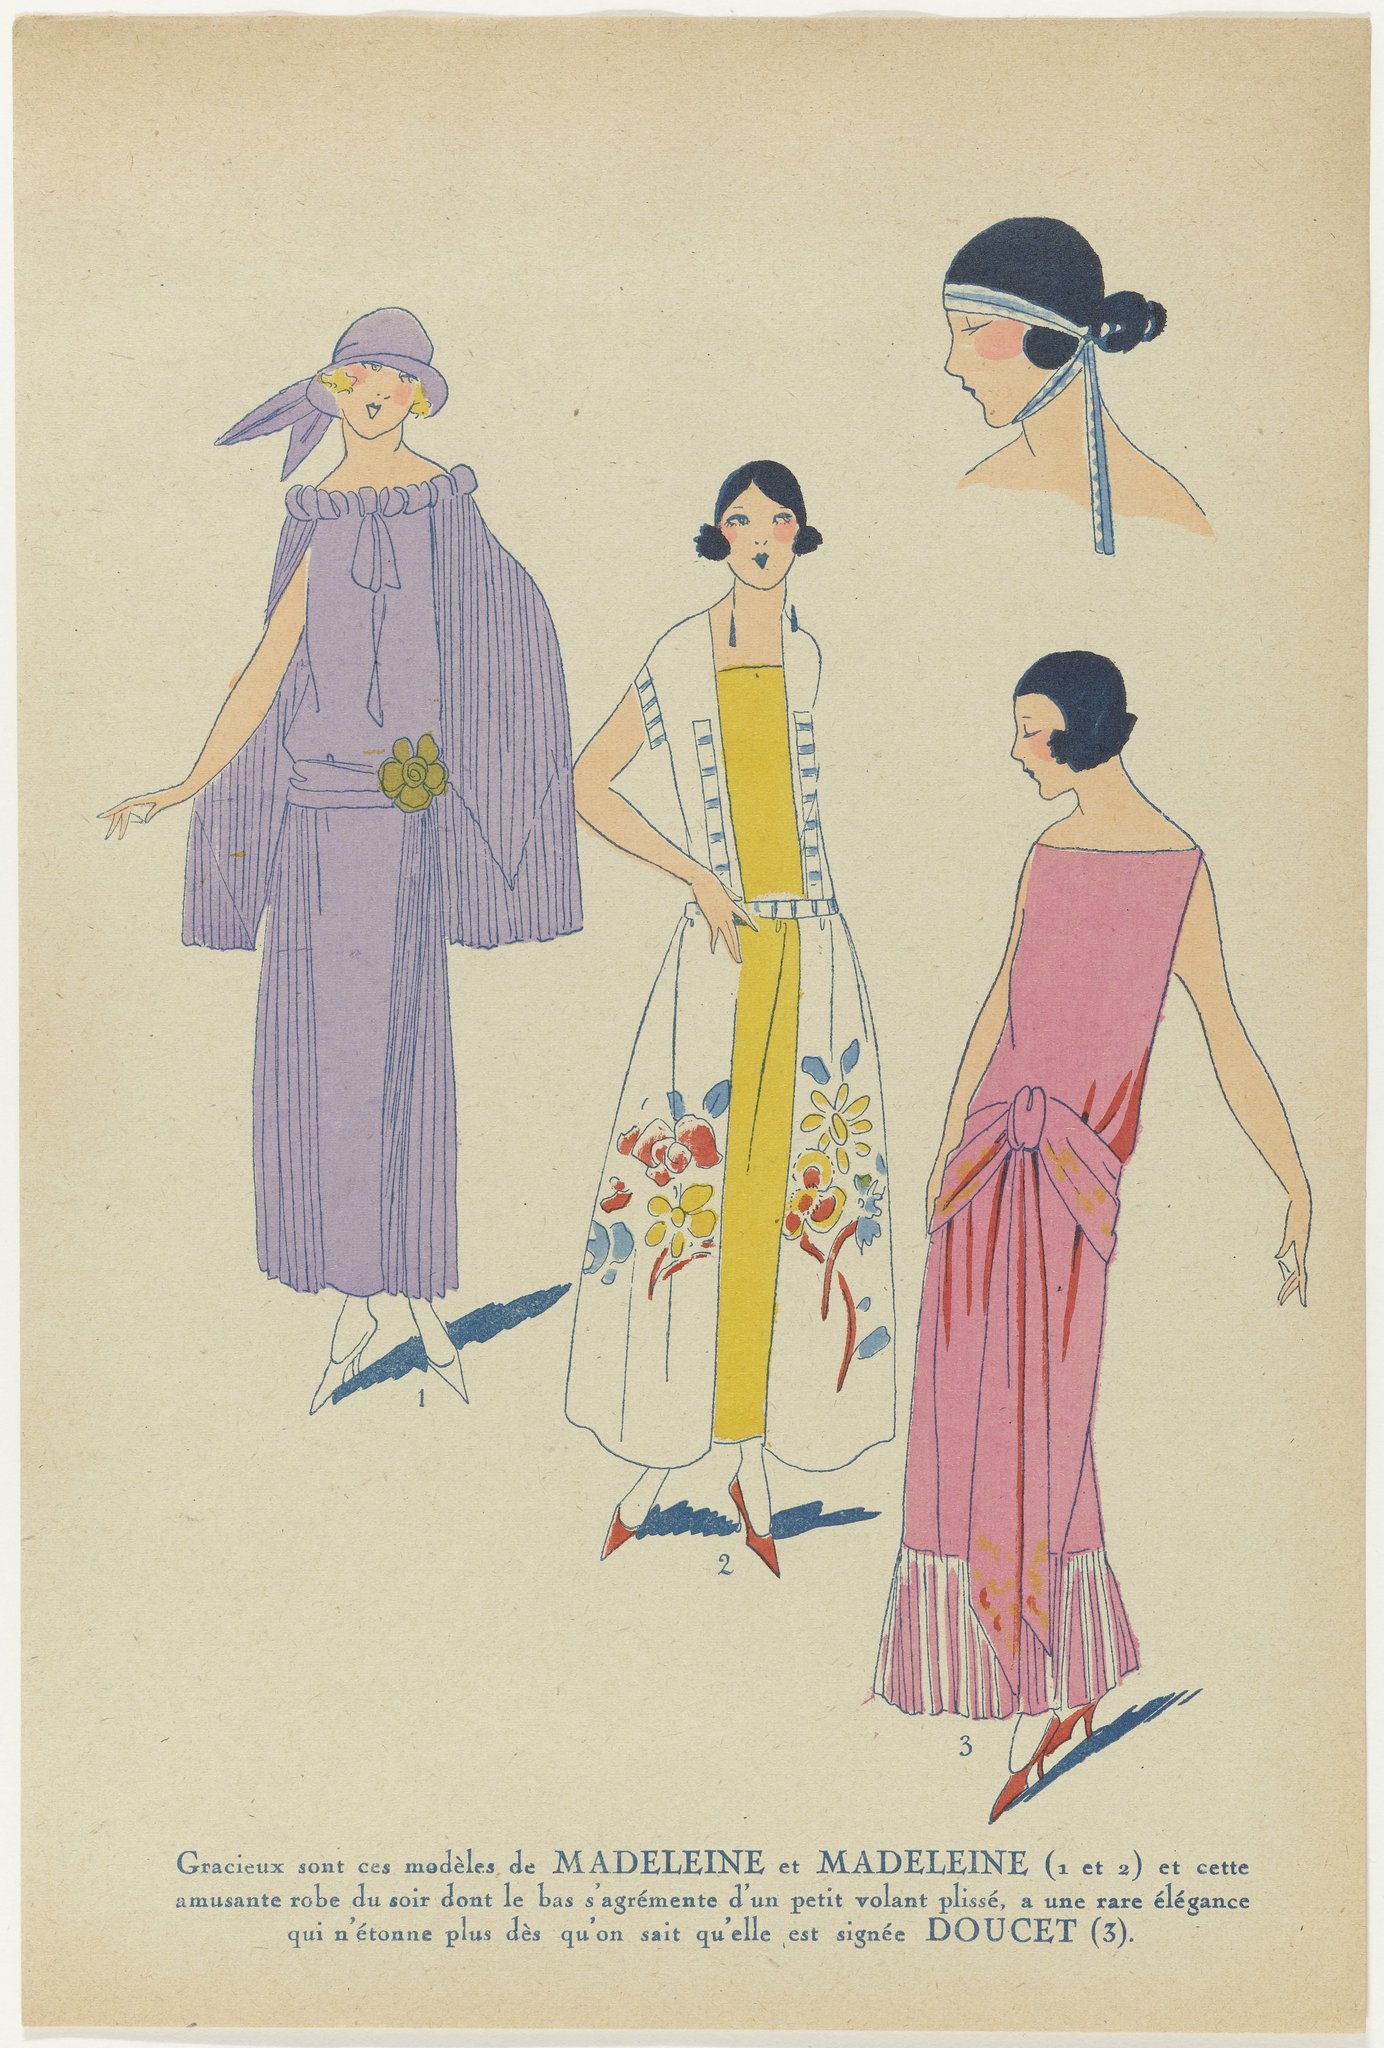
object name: fashion print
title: Très Parisien, 1923, No 6: Gracieux sont ces modèles de Madeleine et Madeleine....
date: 1923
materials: paper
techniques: hand coloring, letterpress printing, lithography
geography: paris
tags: diadem, tiara (+ women's clothes), dress, gown: evening dress (+ women's clothes), fashion plates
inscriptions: caption: ‘Gracieux sont ces modèles de MADELEINE et MADELEINE (1 et 2) et cette amusante robe du soir dont le bas s'agrémente d'un petit volant plissé, a une rare élégance qui n'étonne plus dès qu'on sait qu'elle est signée DOUCET (3).’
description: Nummer 1 en 2: ontwerpen van Madeleine et Madeleine. Nummer 3: avondjurk met aan de onderzijde een kleine geplisseerde volant van Doucet. Prent uit het modetijdschrift Très Parisien (1920-1936).